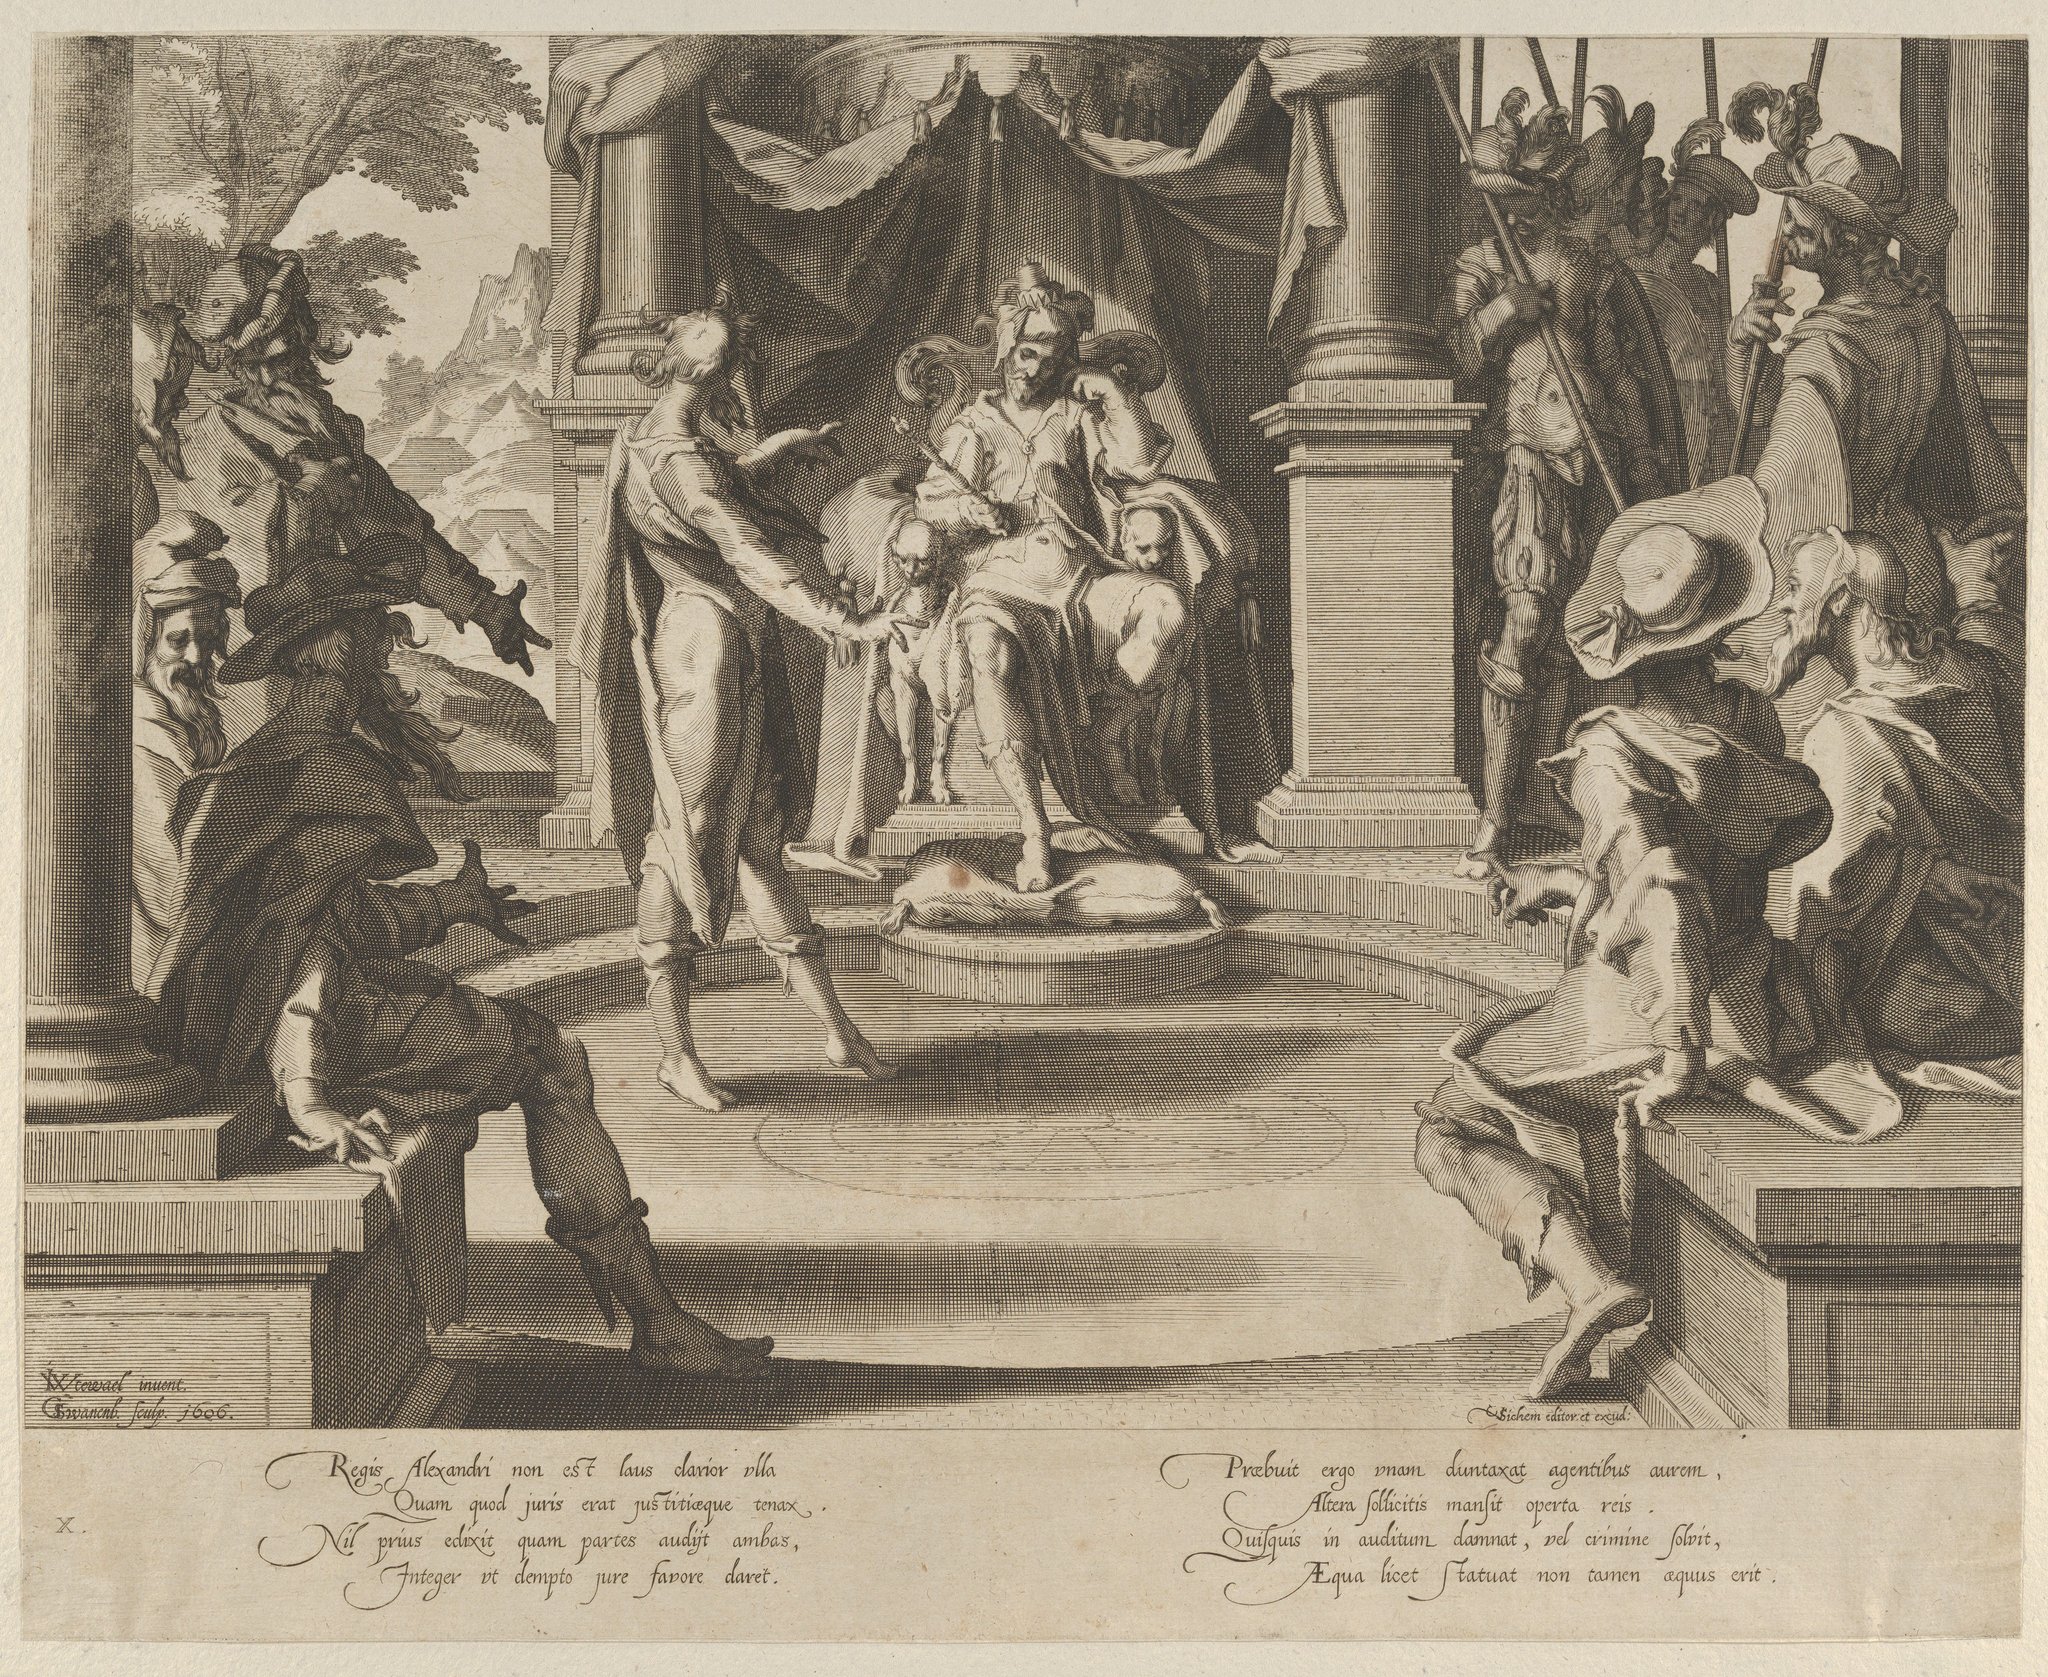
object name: print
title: Alexander the Great as a Judge, plate 10 from "Thronus Justitiae, tredecim pulcherrimus tabulis..."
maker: willem van swanenburg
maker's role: artist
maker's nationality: netherlandish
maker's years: 1581-1612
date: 1605-1606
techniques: engraving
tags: alexander the great,men,women